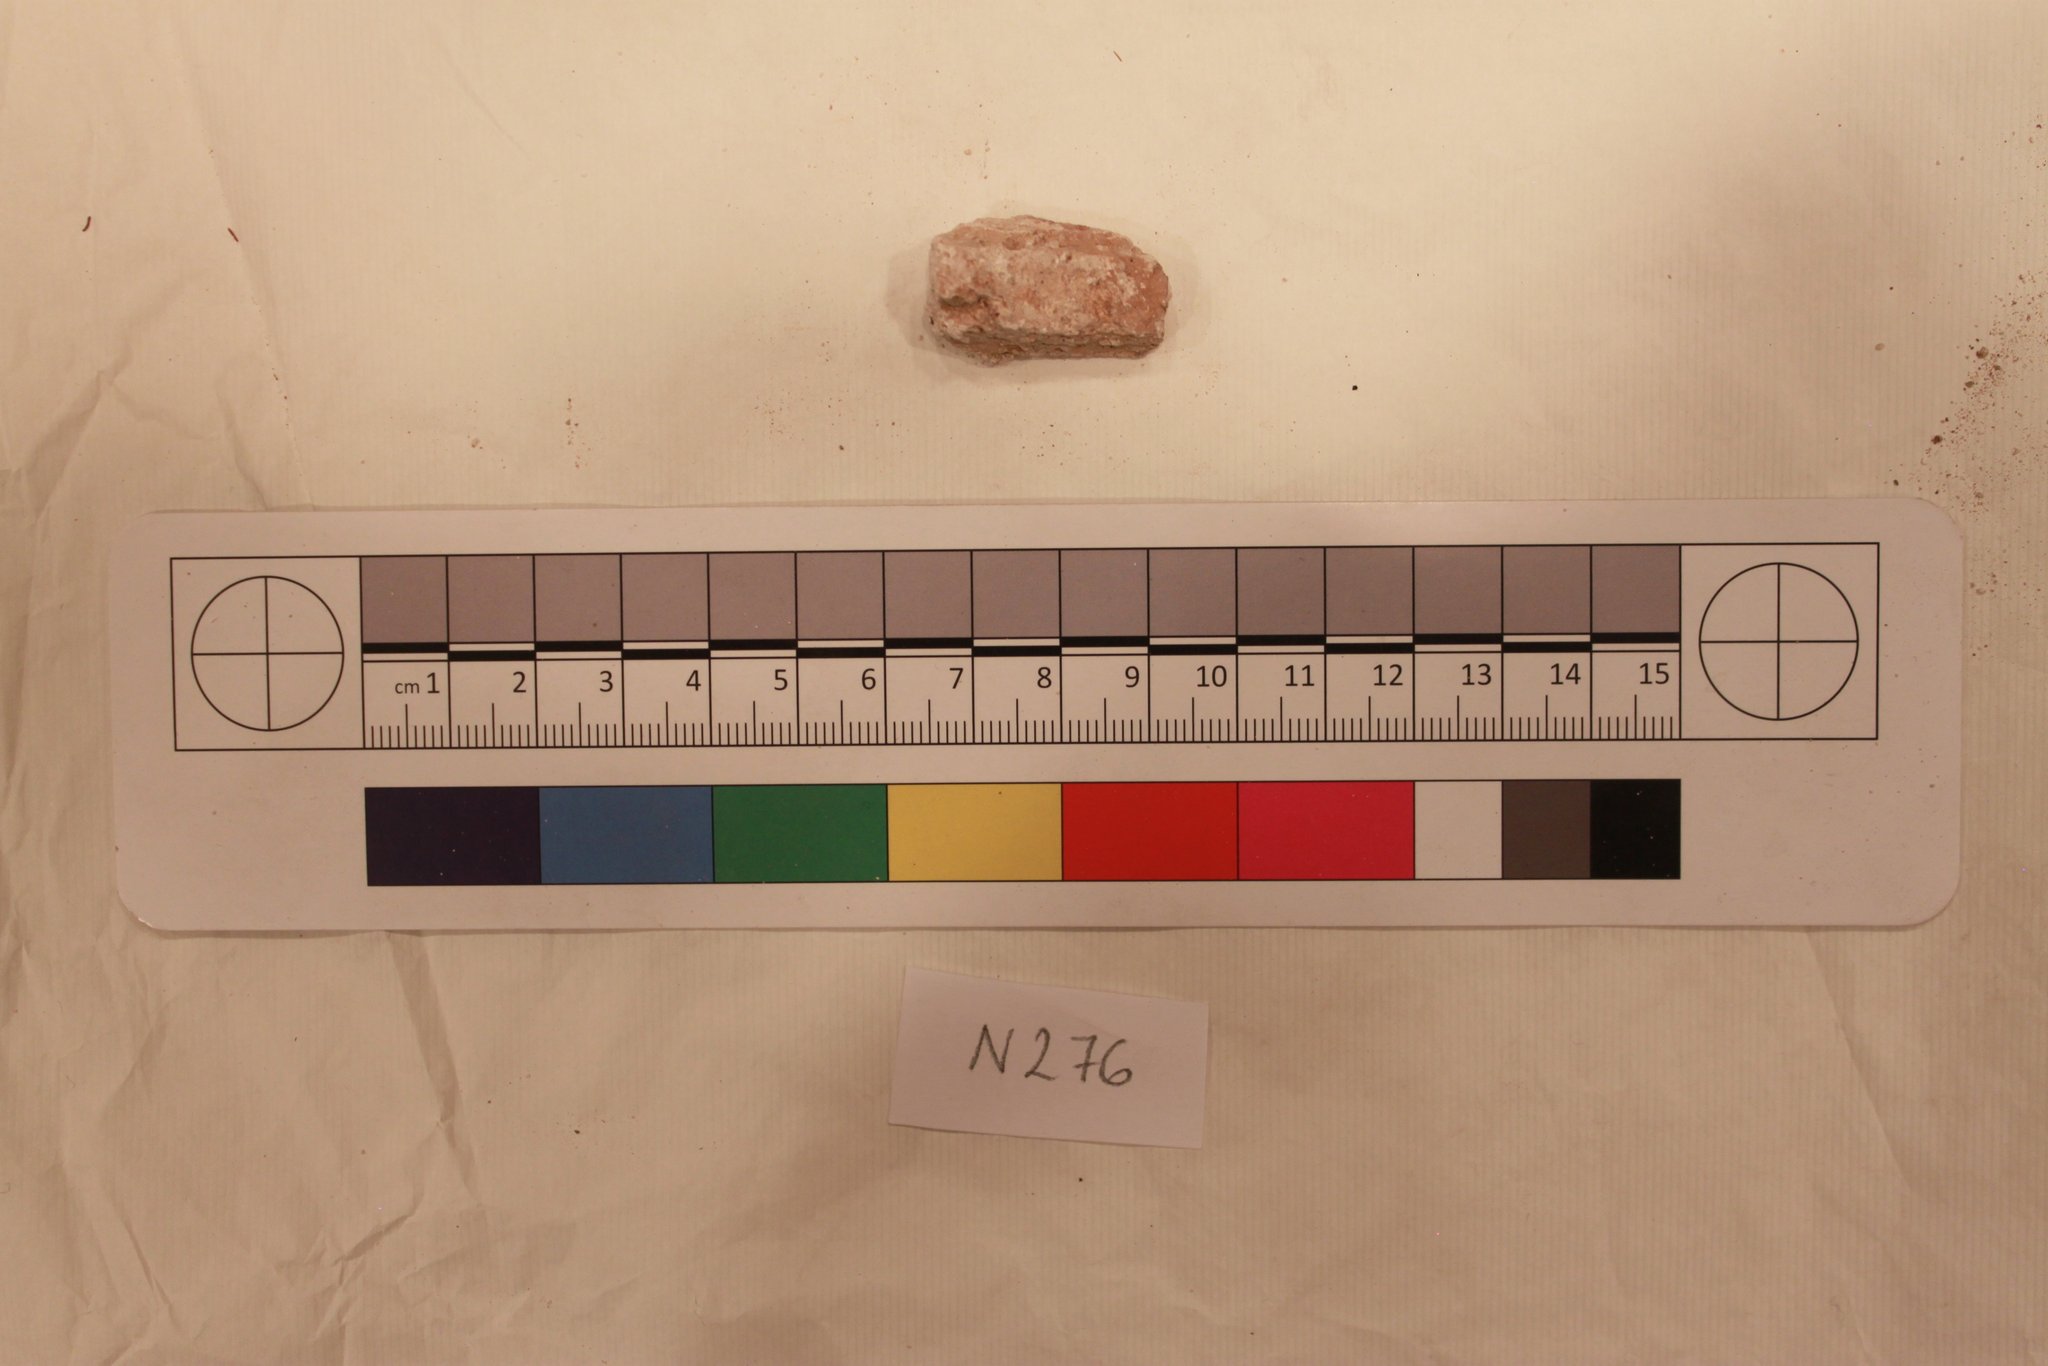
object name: fragment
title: Stucco Fragment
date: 701-1200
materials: plaster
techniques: carving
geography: iran